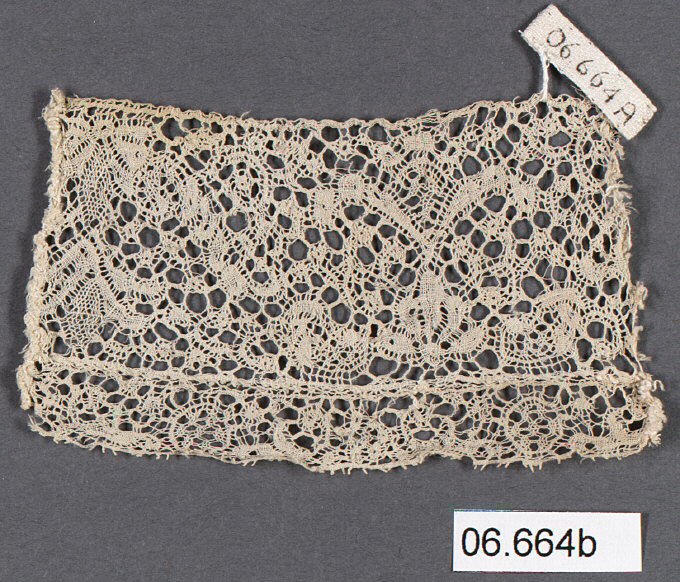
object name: fragment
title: Fragment of bobbin lace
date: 1700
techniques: lace